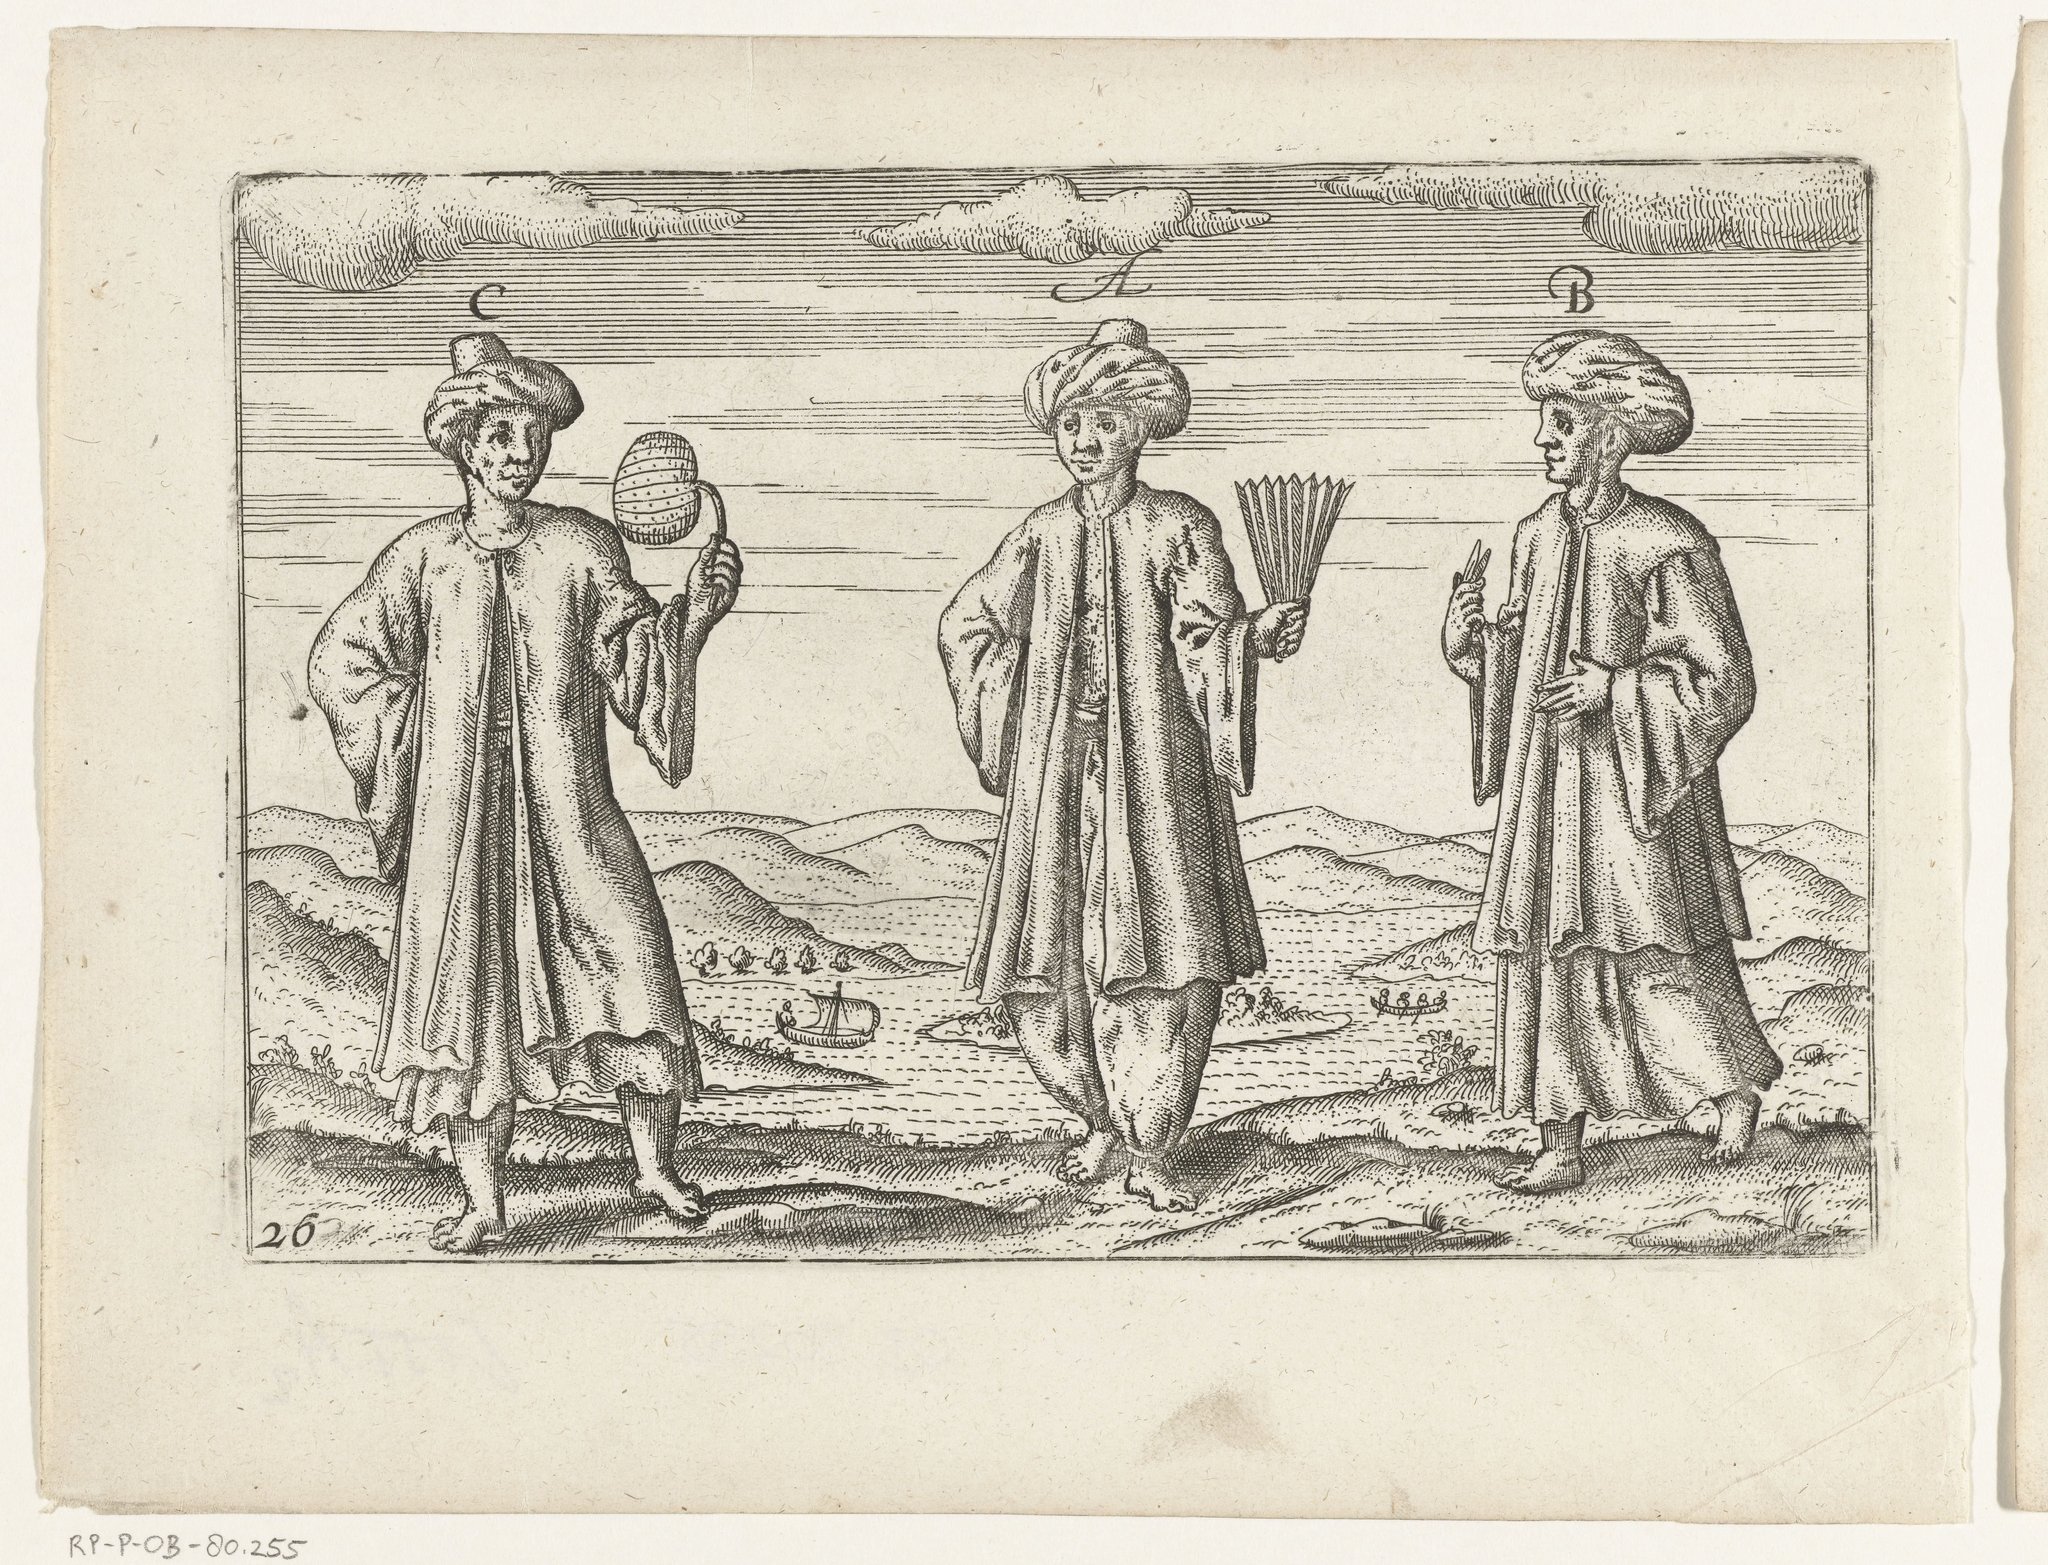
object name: print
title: Arabische koopmannen te Bantam, 1596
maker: Anonymous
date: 1597-1598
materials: paper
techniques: engraving, etching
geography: northern netherlands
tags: gouda, landscapes in tropical and sub-tropical regions, exploration, expedition, voyage of discovery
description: Gebruikt als illustratie eerst in: Willem Lodewijcksz, D'eerste boeck. Historie van Indien, waer inne verhaelt is de avontueren die de Hollandtsche schepen bejeghent zijn, Cornelis Claes, Amsterdam 1598. In deze opgewerkte staat gebruikt in: De Eerste Schipvaerd der Hollandsche Natie naer Oost-Indien, waer inne verhaelt wordt al wat haer sonderlings onder wegen bejegent is ... ghetrocken uyt verscheyden Iournalen ofte dagh-registers daer van ghemaeckt, zeer vermaeckelijck ende nut om lesen. Opgenomen in: I. Commelin, Begin ende voortgangh, van de Vereenighde Nederlantsche Geoctroyeerde Oost-Indische Compagnie, J. Janssonius, Amsterdam 1646. Genummerd: 26.